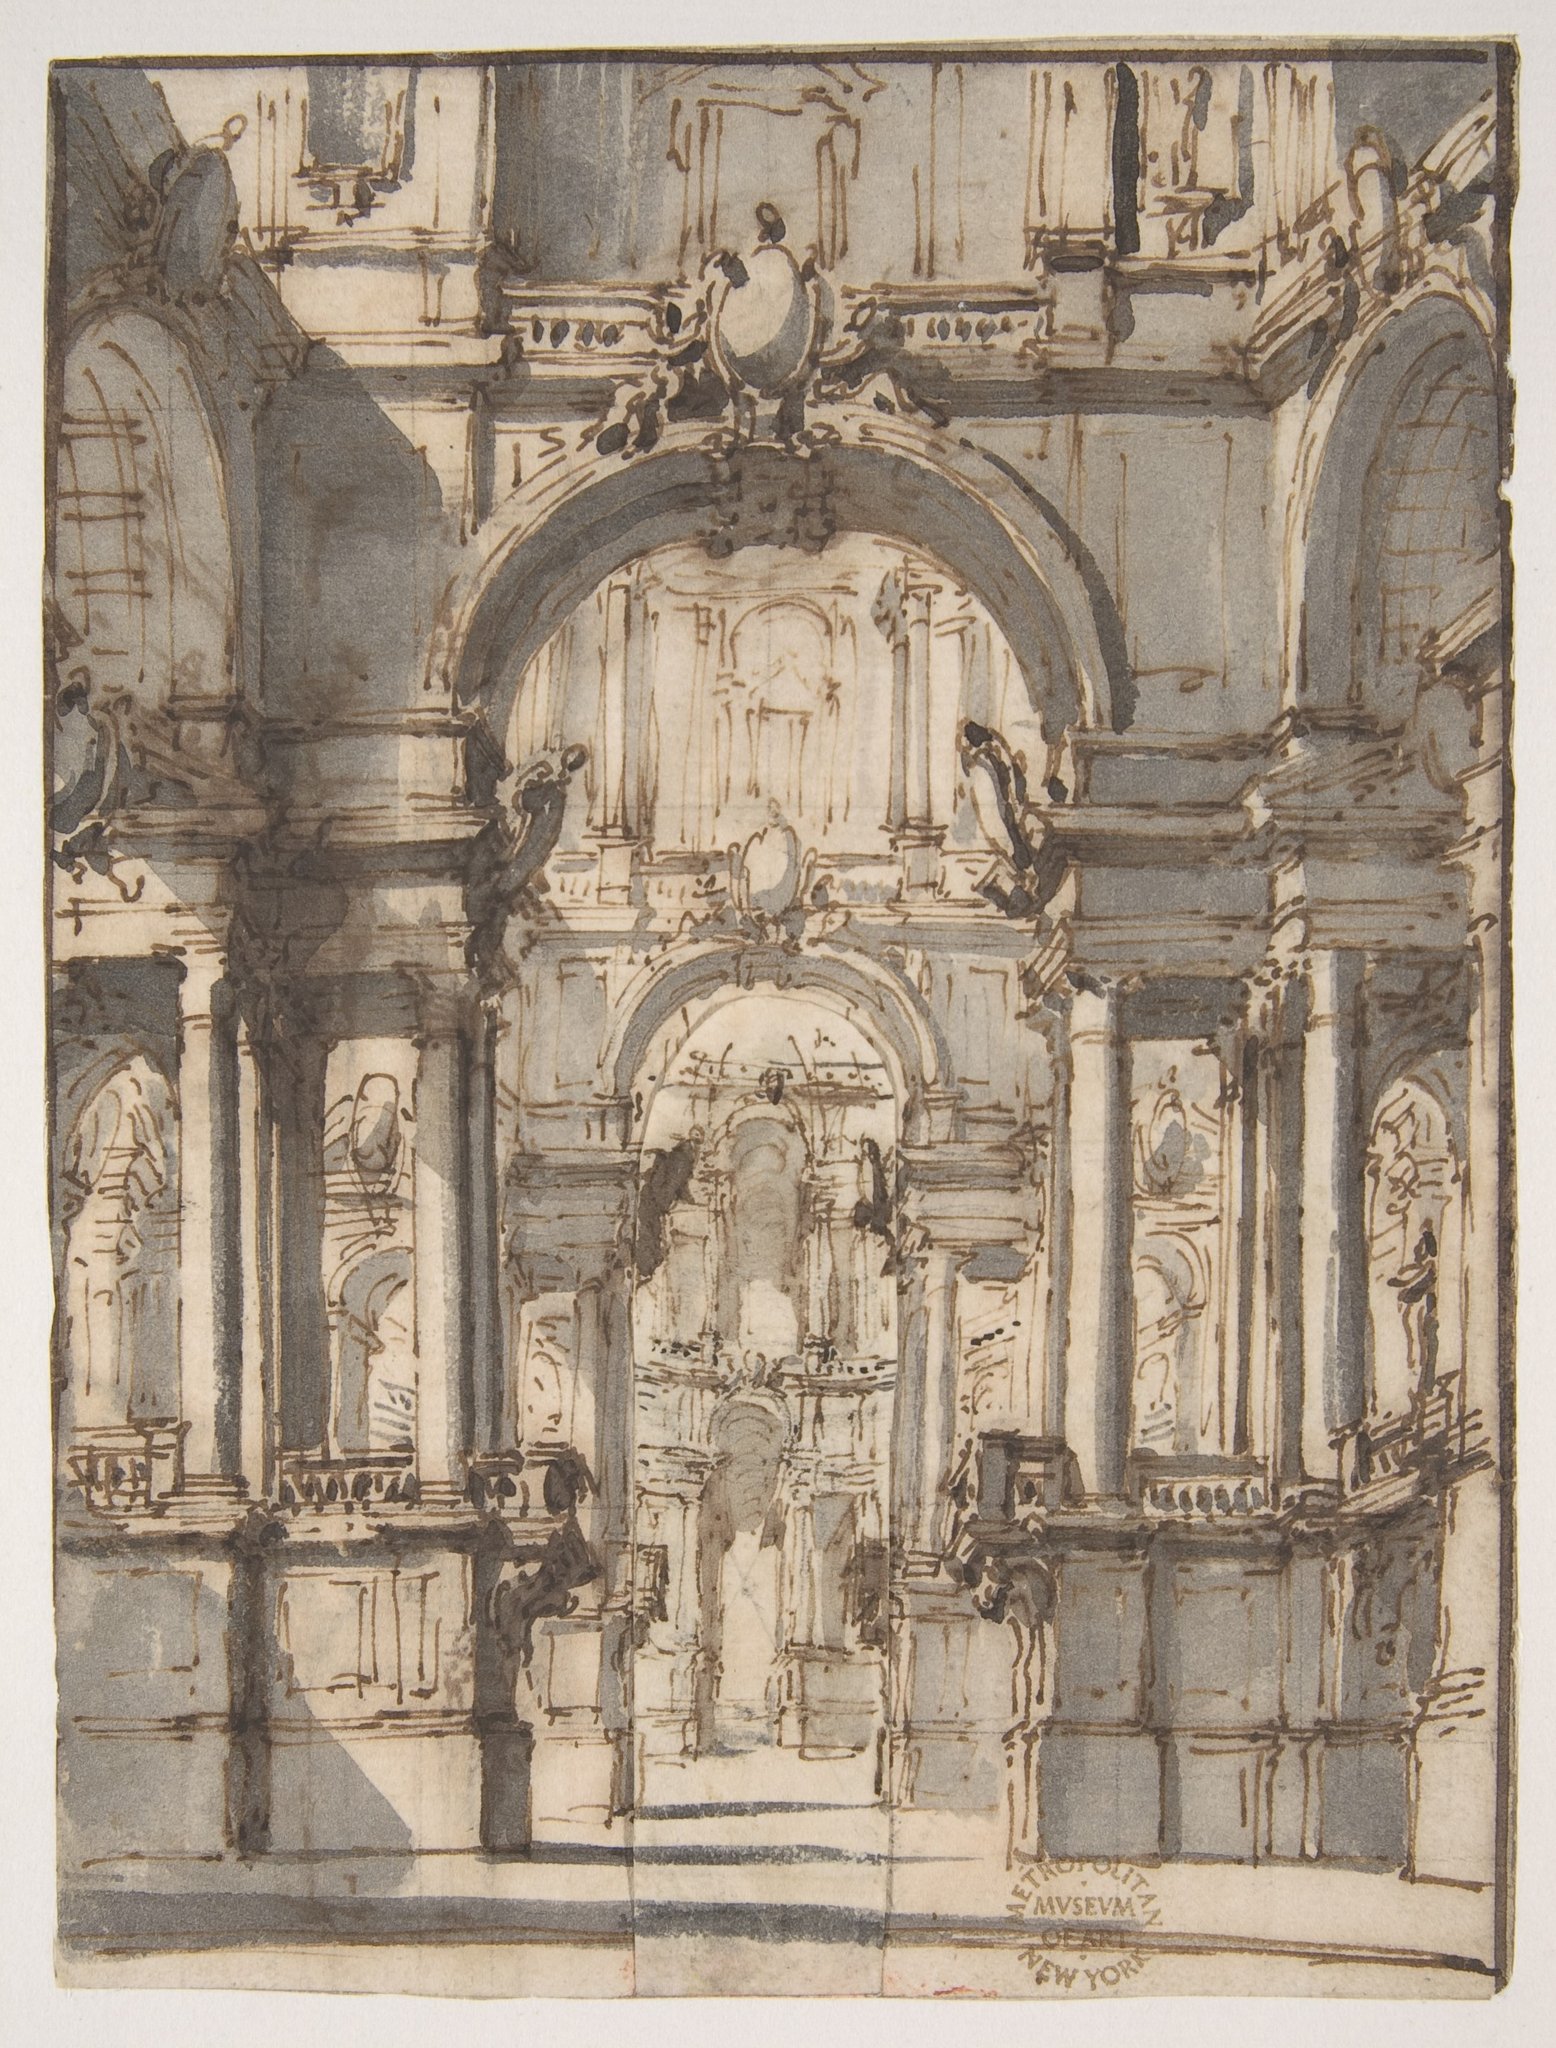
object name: drawing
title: Design for a Stage Set (recto); Fragmentary Sketch of a Stage Set in Elevation (verso)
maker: giovanni battista natali iii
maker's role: artist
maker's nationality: italian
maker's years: 1698-1765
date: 1698-1765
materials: ink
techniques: brush, pen, wash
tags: stage design